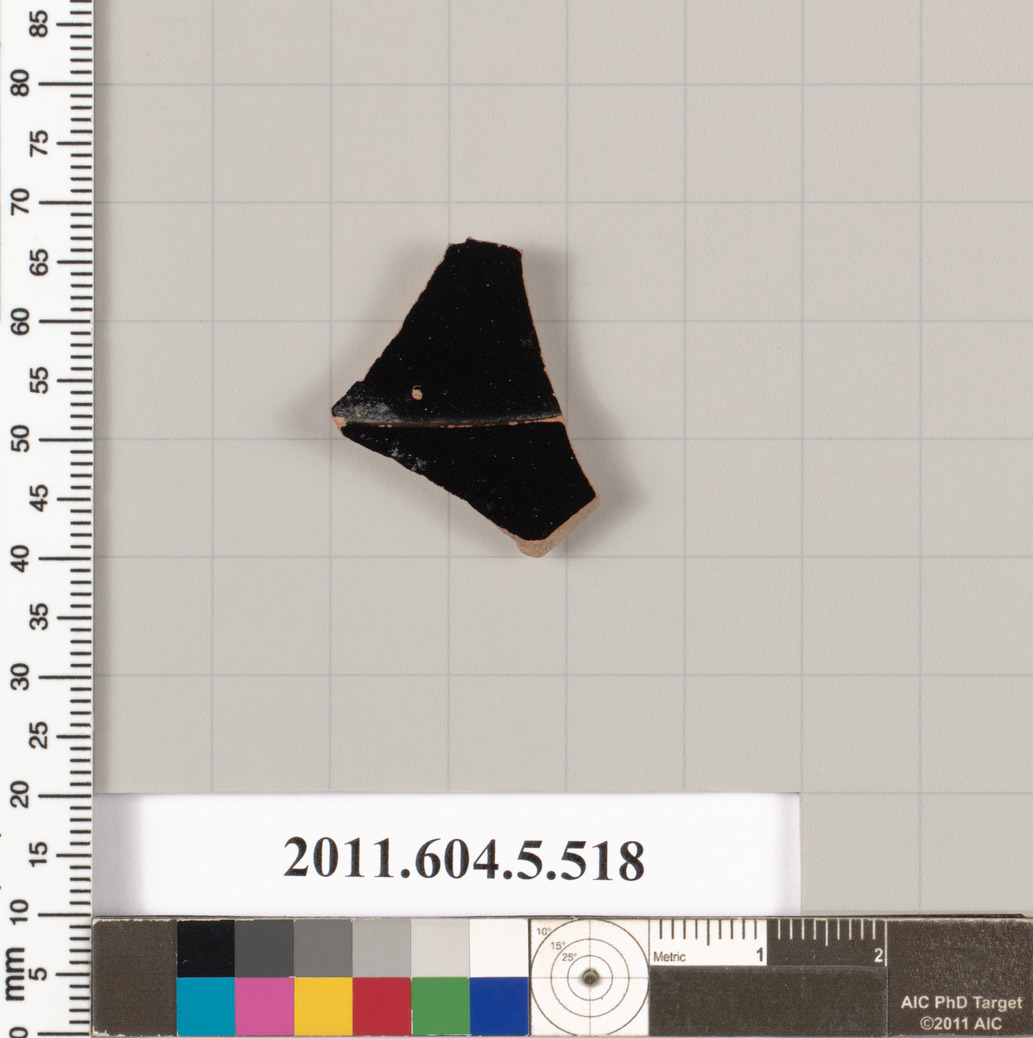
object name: kylix fragment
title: Terracotta fragment of a kylix (drinking cup)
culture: greek, attic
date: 600-401 BCE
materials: terracotta